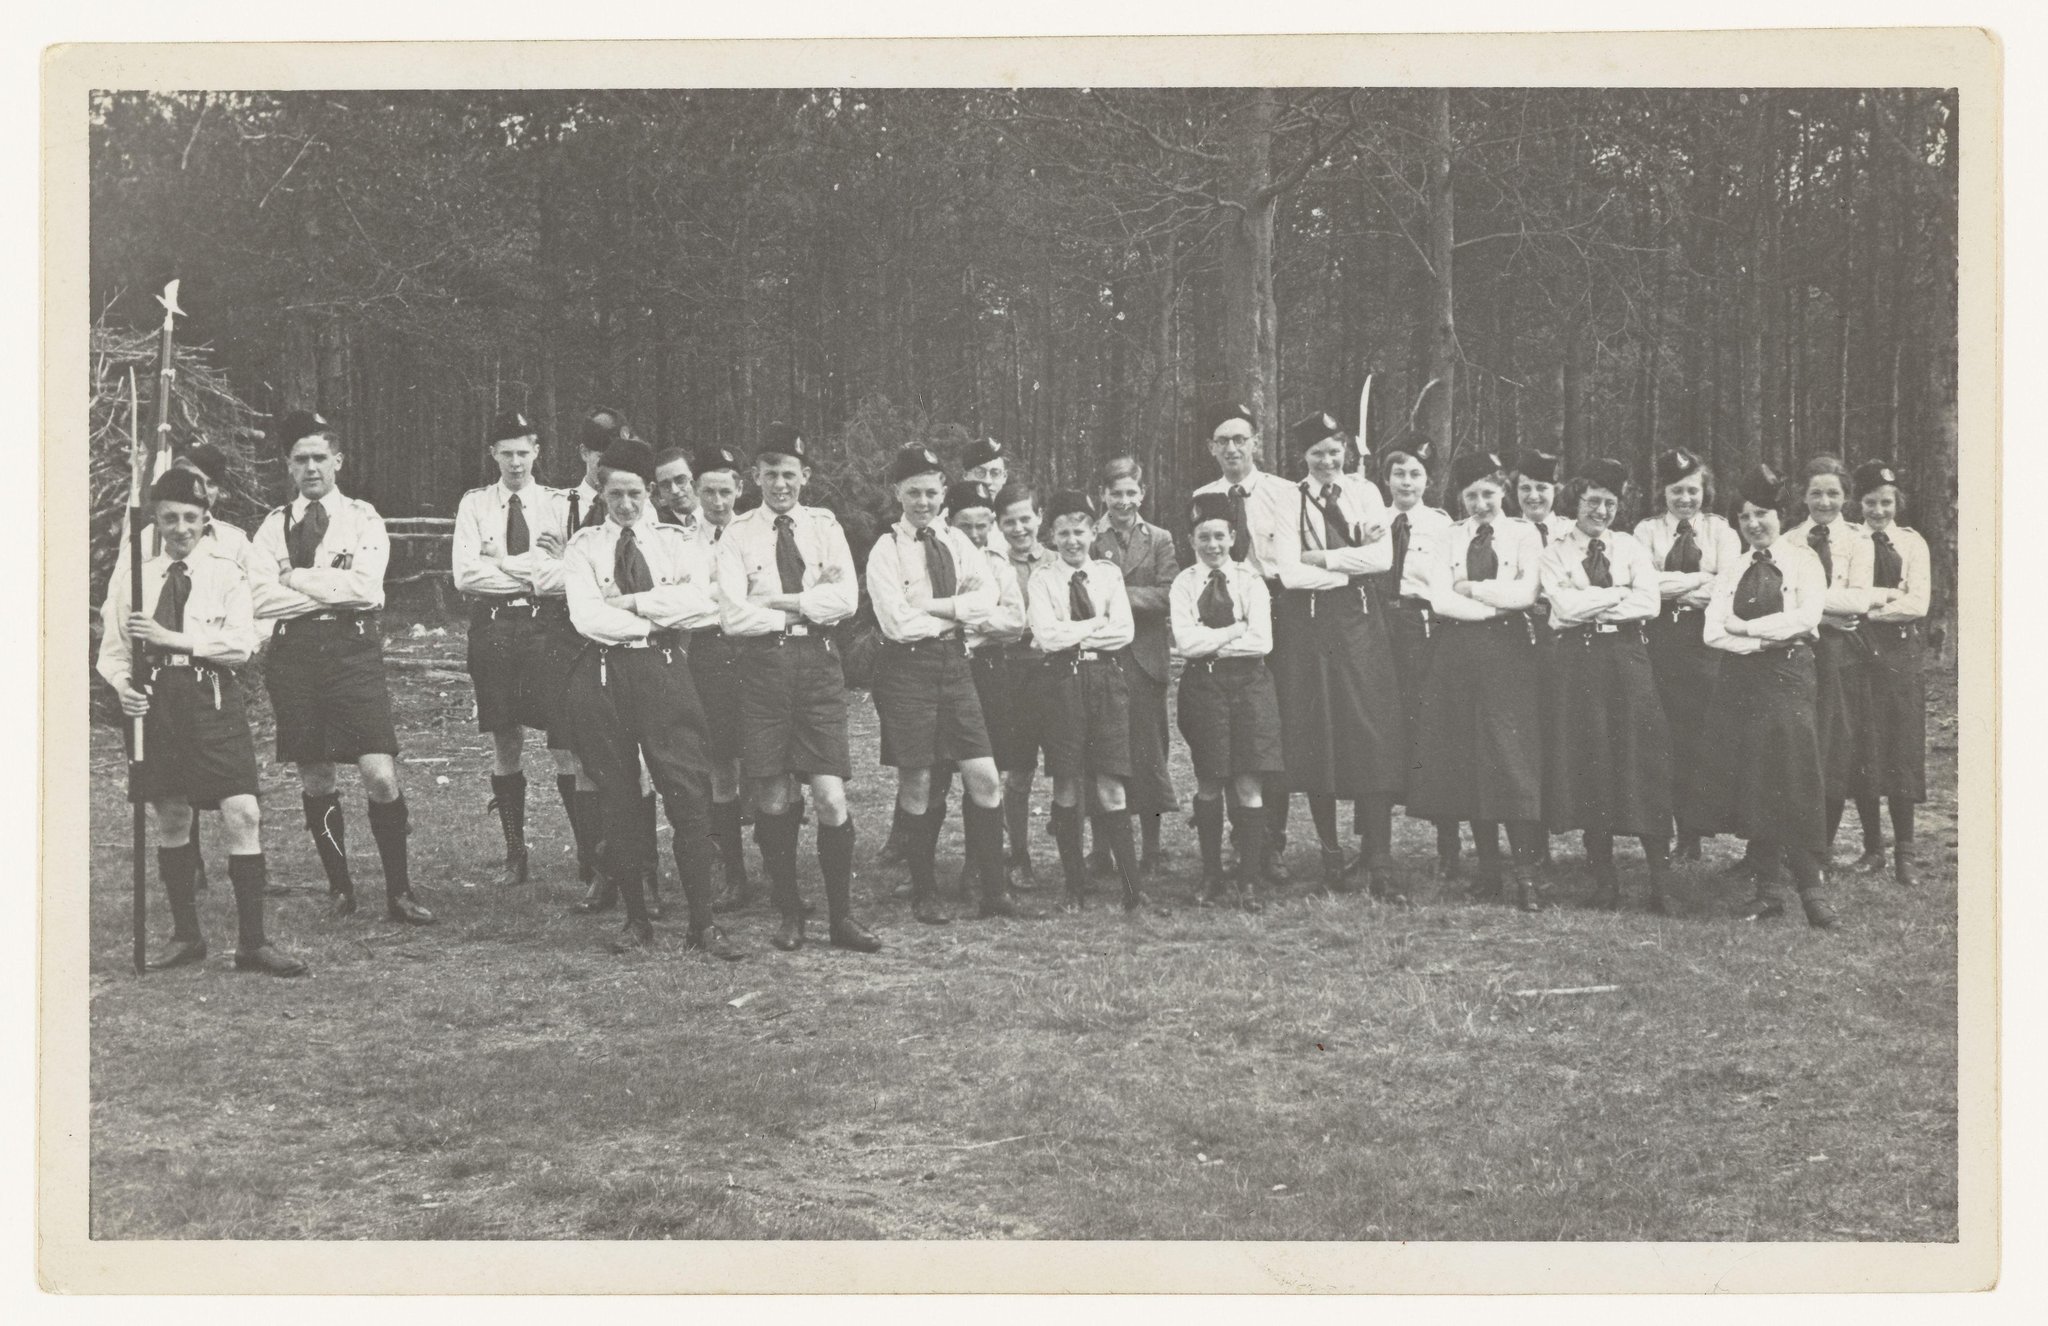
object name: photograph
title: Jeugdstorm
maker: j. otto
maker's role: fotograaf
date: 1935-1937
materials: photographic support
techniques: gelatin silver print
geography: zeist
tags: military parade, pageant, zeist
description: In een bosachtige omgeving staan jongens en meisjes van de Jeugdstorm en hun aanvoerders in uniform in informele houding, vermoedelijk na afloop van de optocht. Twee jongens dragen geen uniform. Links is nog een deel van de houtstapel te zien.